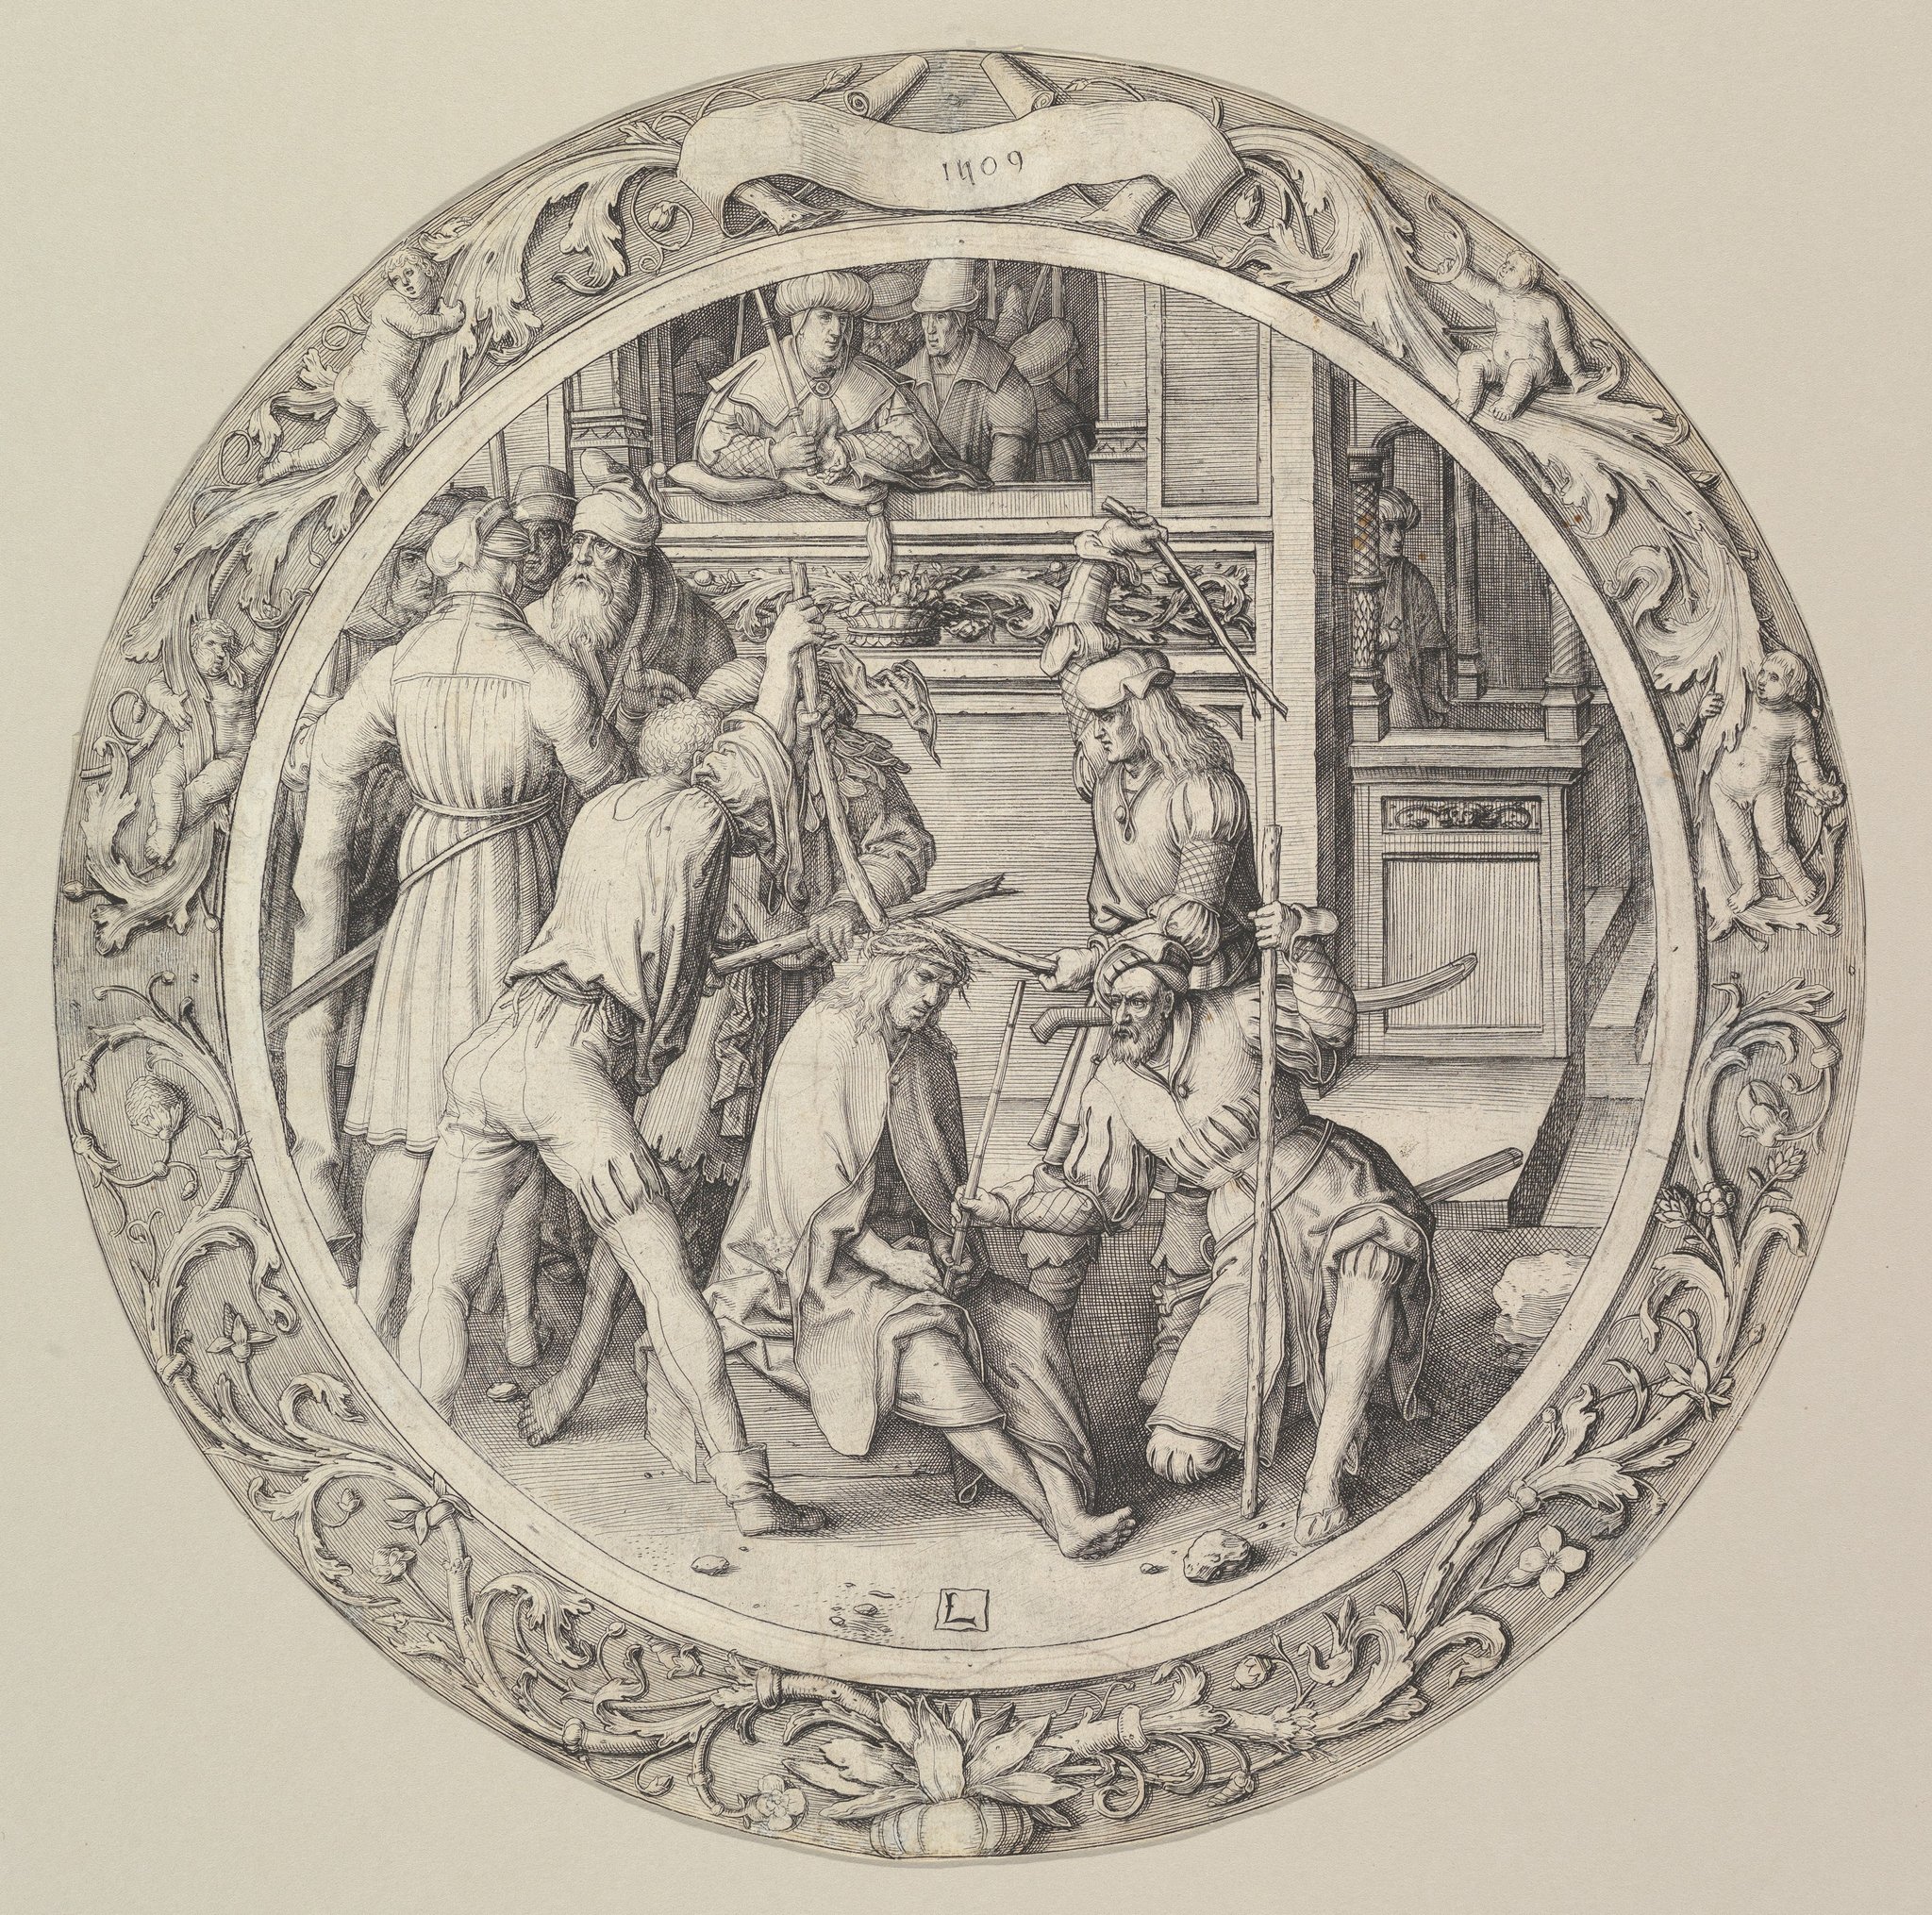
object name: print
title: Christ Crowned with Thorns, from the Circular Passion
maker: lucas van leyden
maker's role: artist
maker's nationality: netherlandish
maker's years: 1494-1533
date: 1509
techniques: engraving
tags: suffering,men,christ